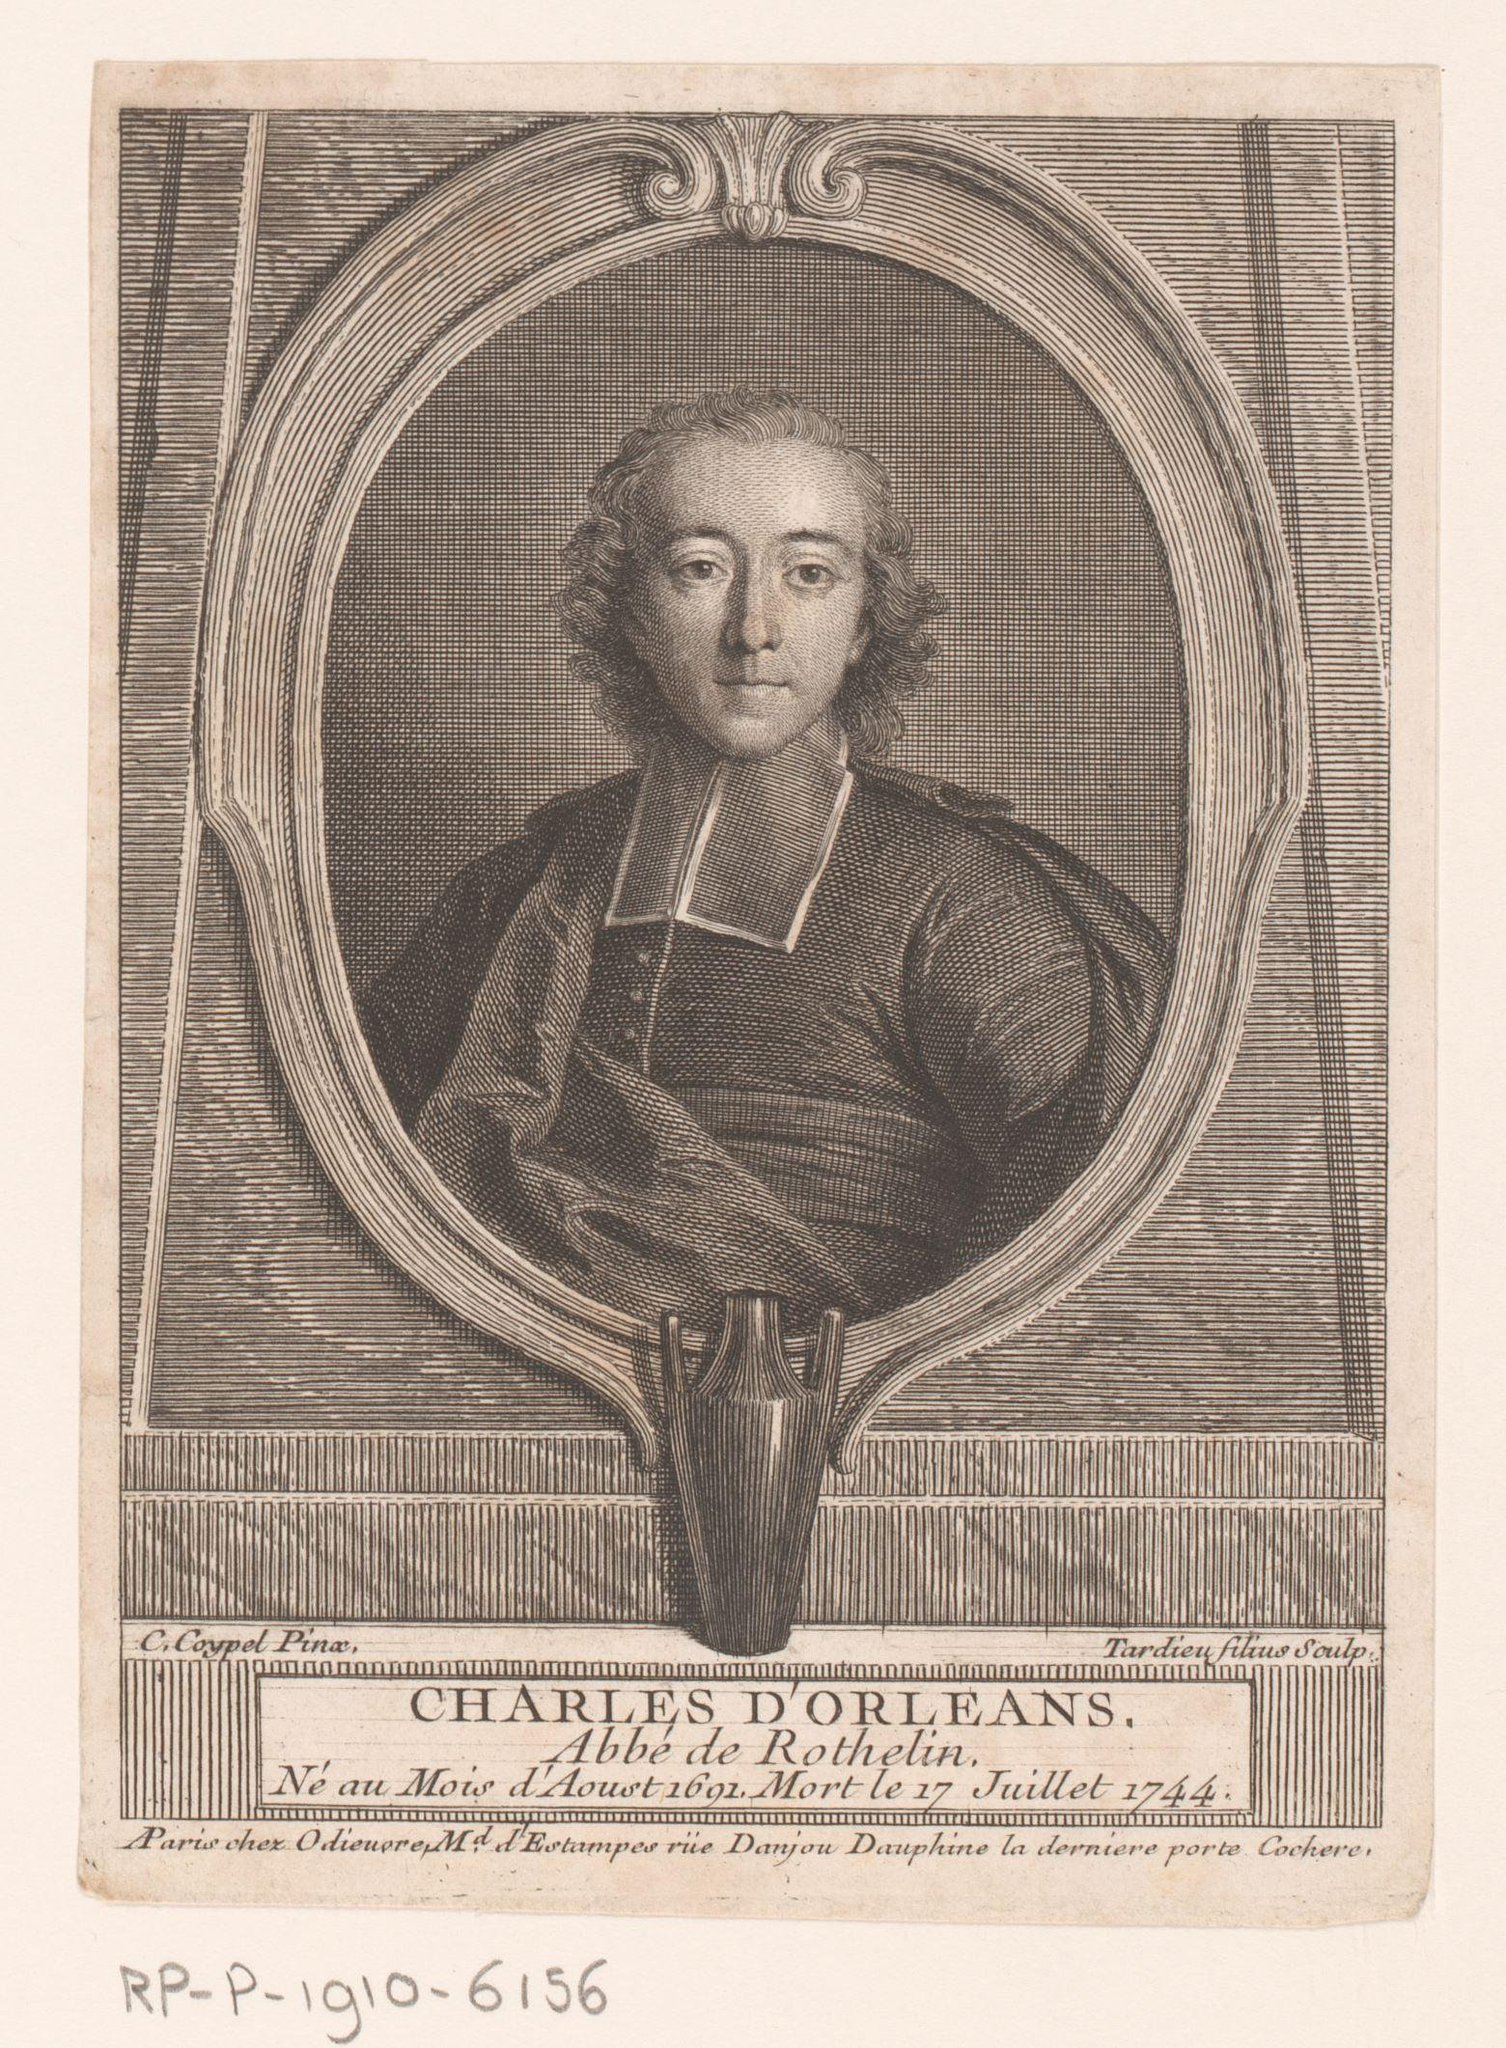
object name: print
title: Portret van Charles d'Orléans de Rothelin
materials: paper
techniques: engraving, etching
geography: paris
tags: paris, priest, historical persons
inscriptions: collector's mark: Lugt 2228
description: Prent als illustratie gebruikt voor het boek: Martin, Gabriel. Catalogue des livres de feu M. l'Abbé d'Orléans de Rothelin. Parijs: Gabriel Martin, 1746.